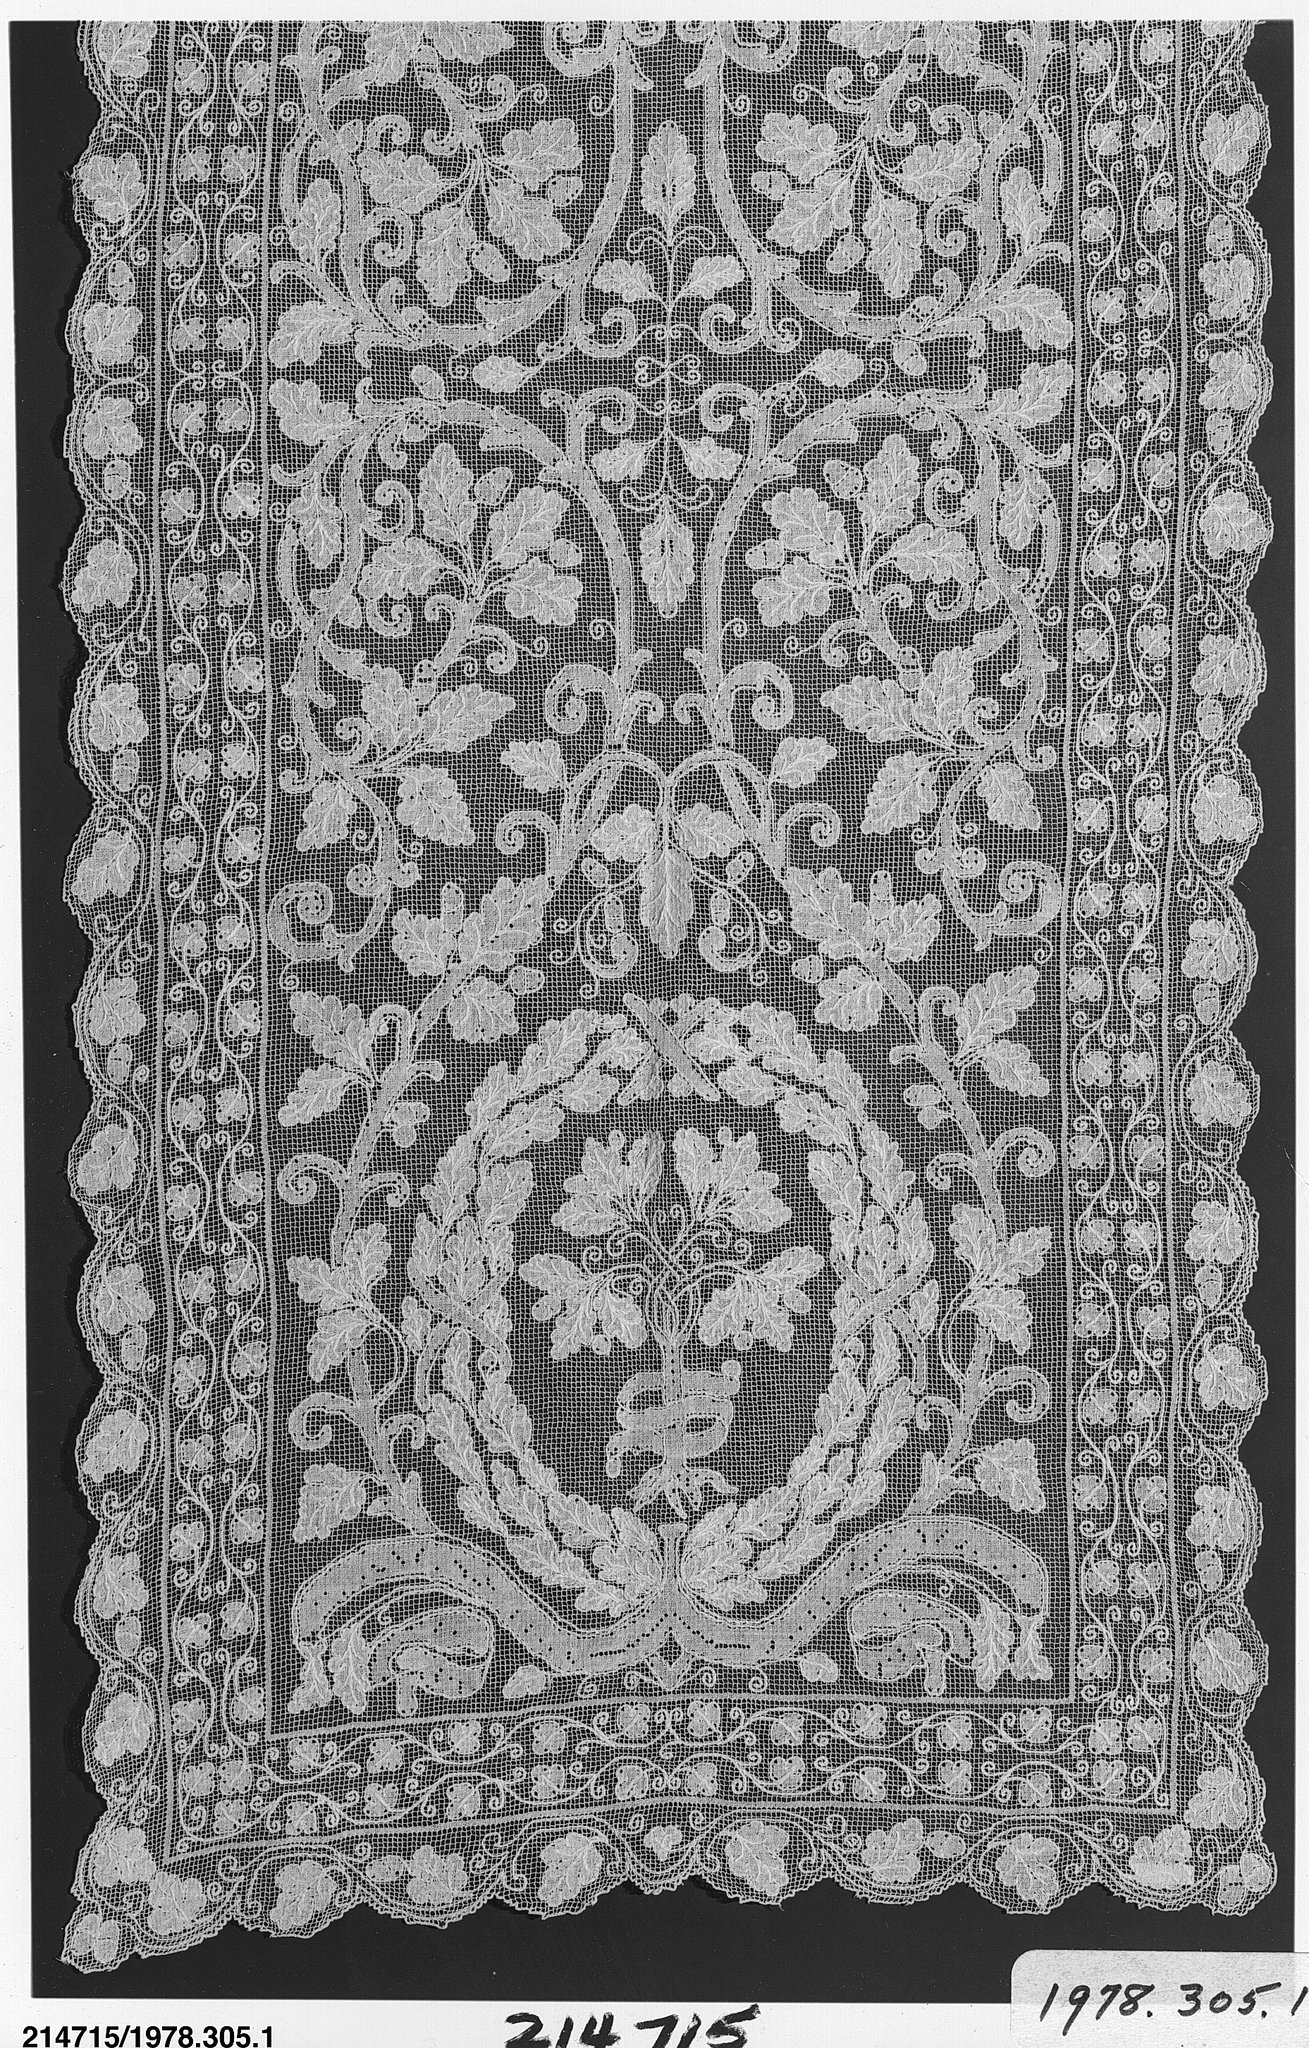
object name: runner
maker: antonio pollaiuolo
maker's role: artist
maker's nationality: italian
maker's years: 1432-1498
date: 1801-1900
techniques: embroidery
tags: flowers